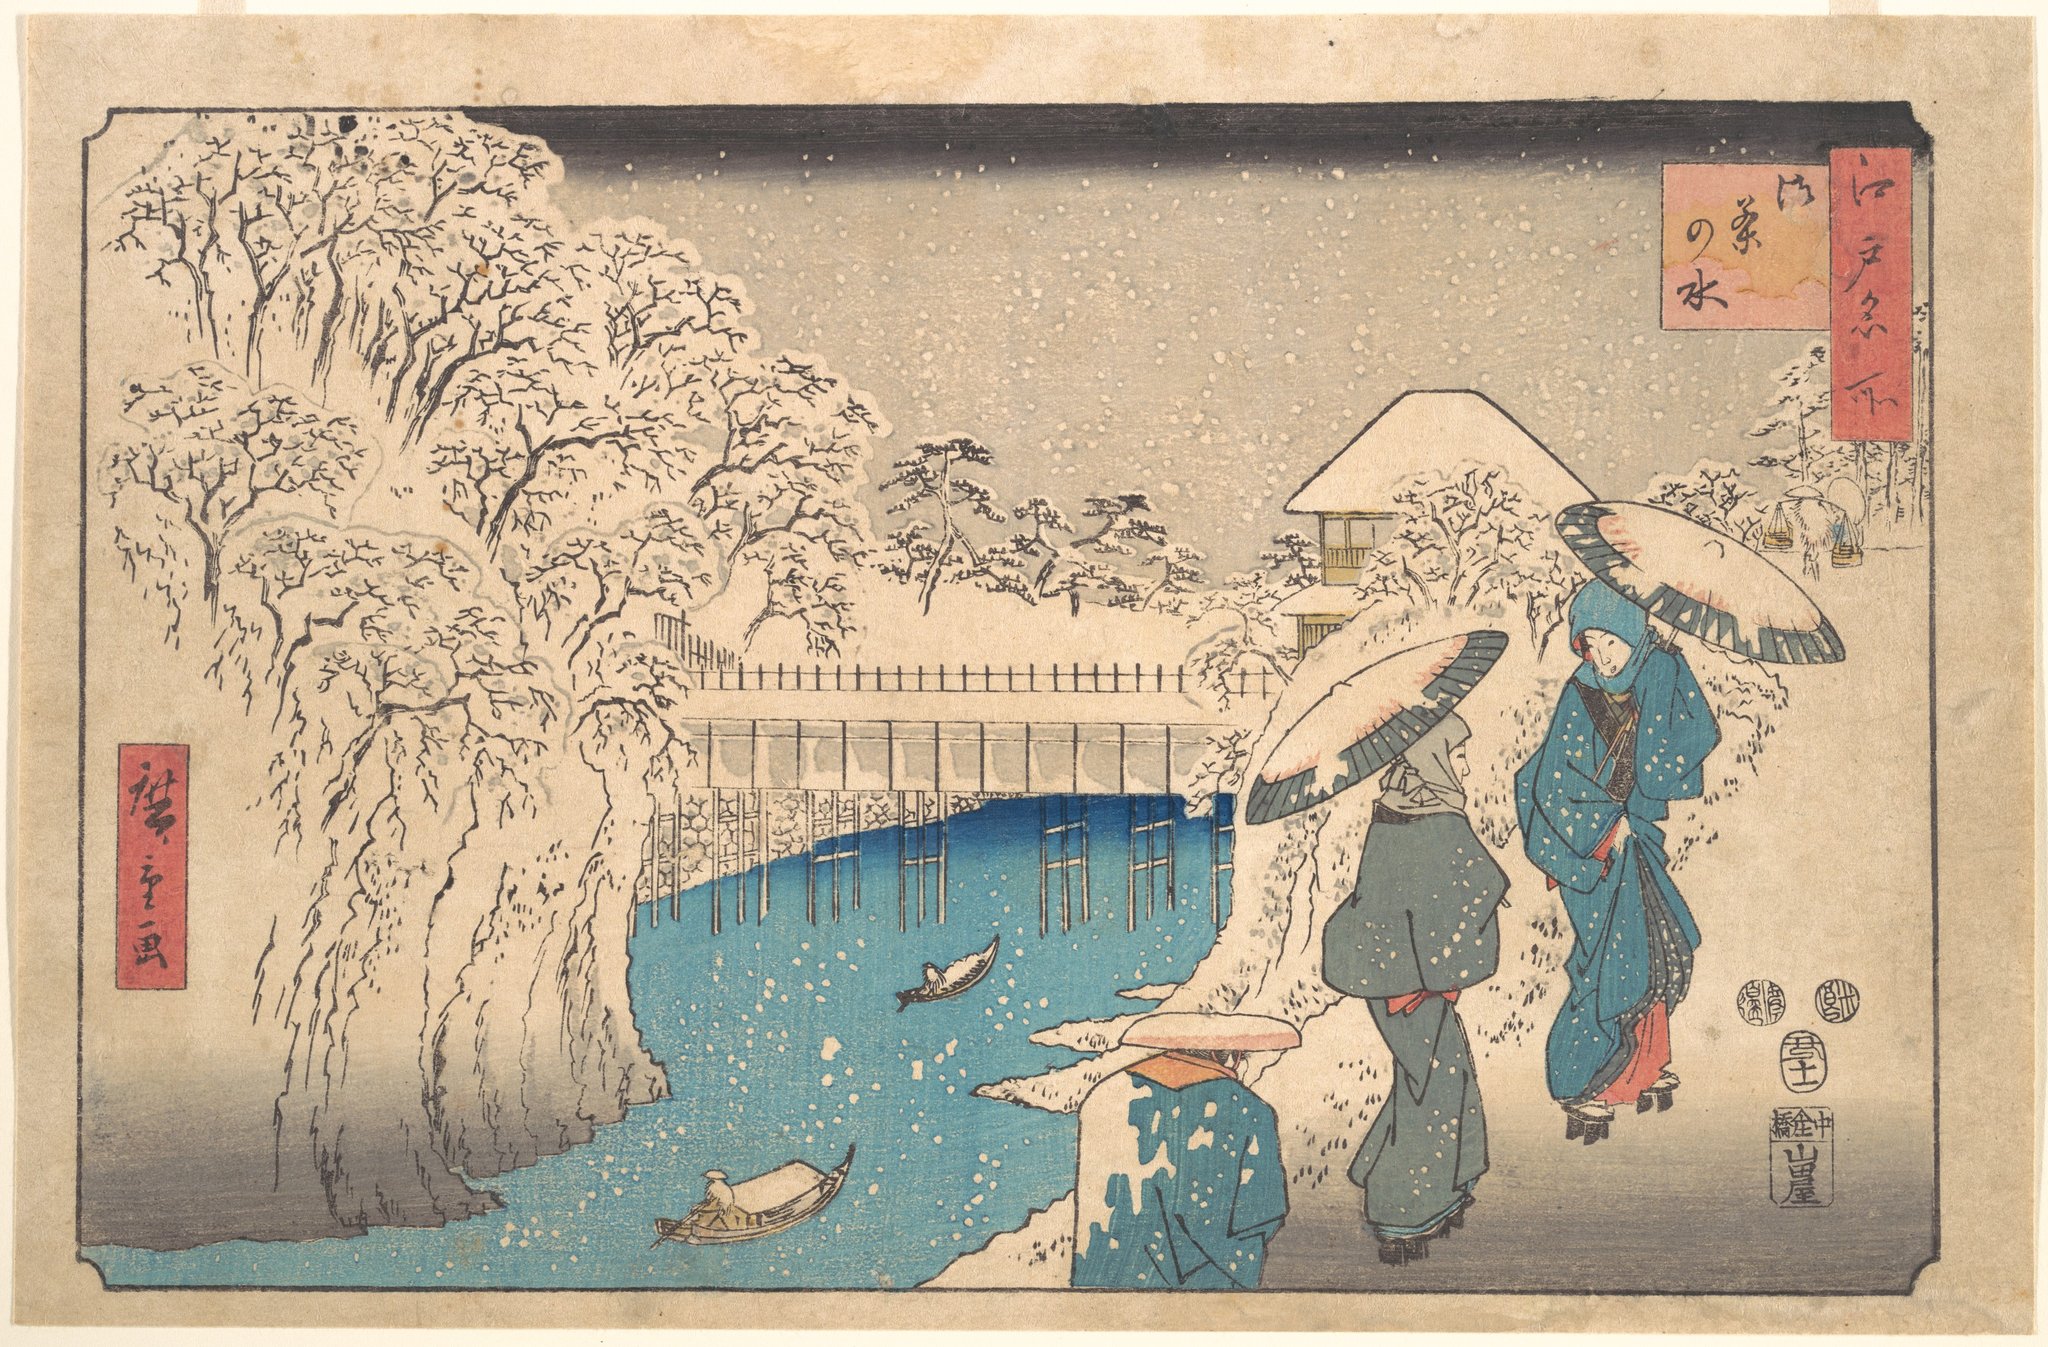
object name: print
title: Meguro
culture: japanese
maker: utagawa hiroshige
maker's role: artist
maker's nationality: japanese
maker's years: 1797-1858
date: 1901-1933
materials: ink, paper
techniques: woodblock print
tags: bridges,women,trees,snow,boats